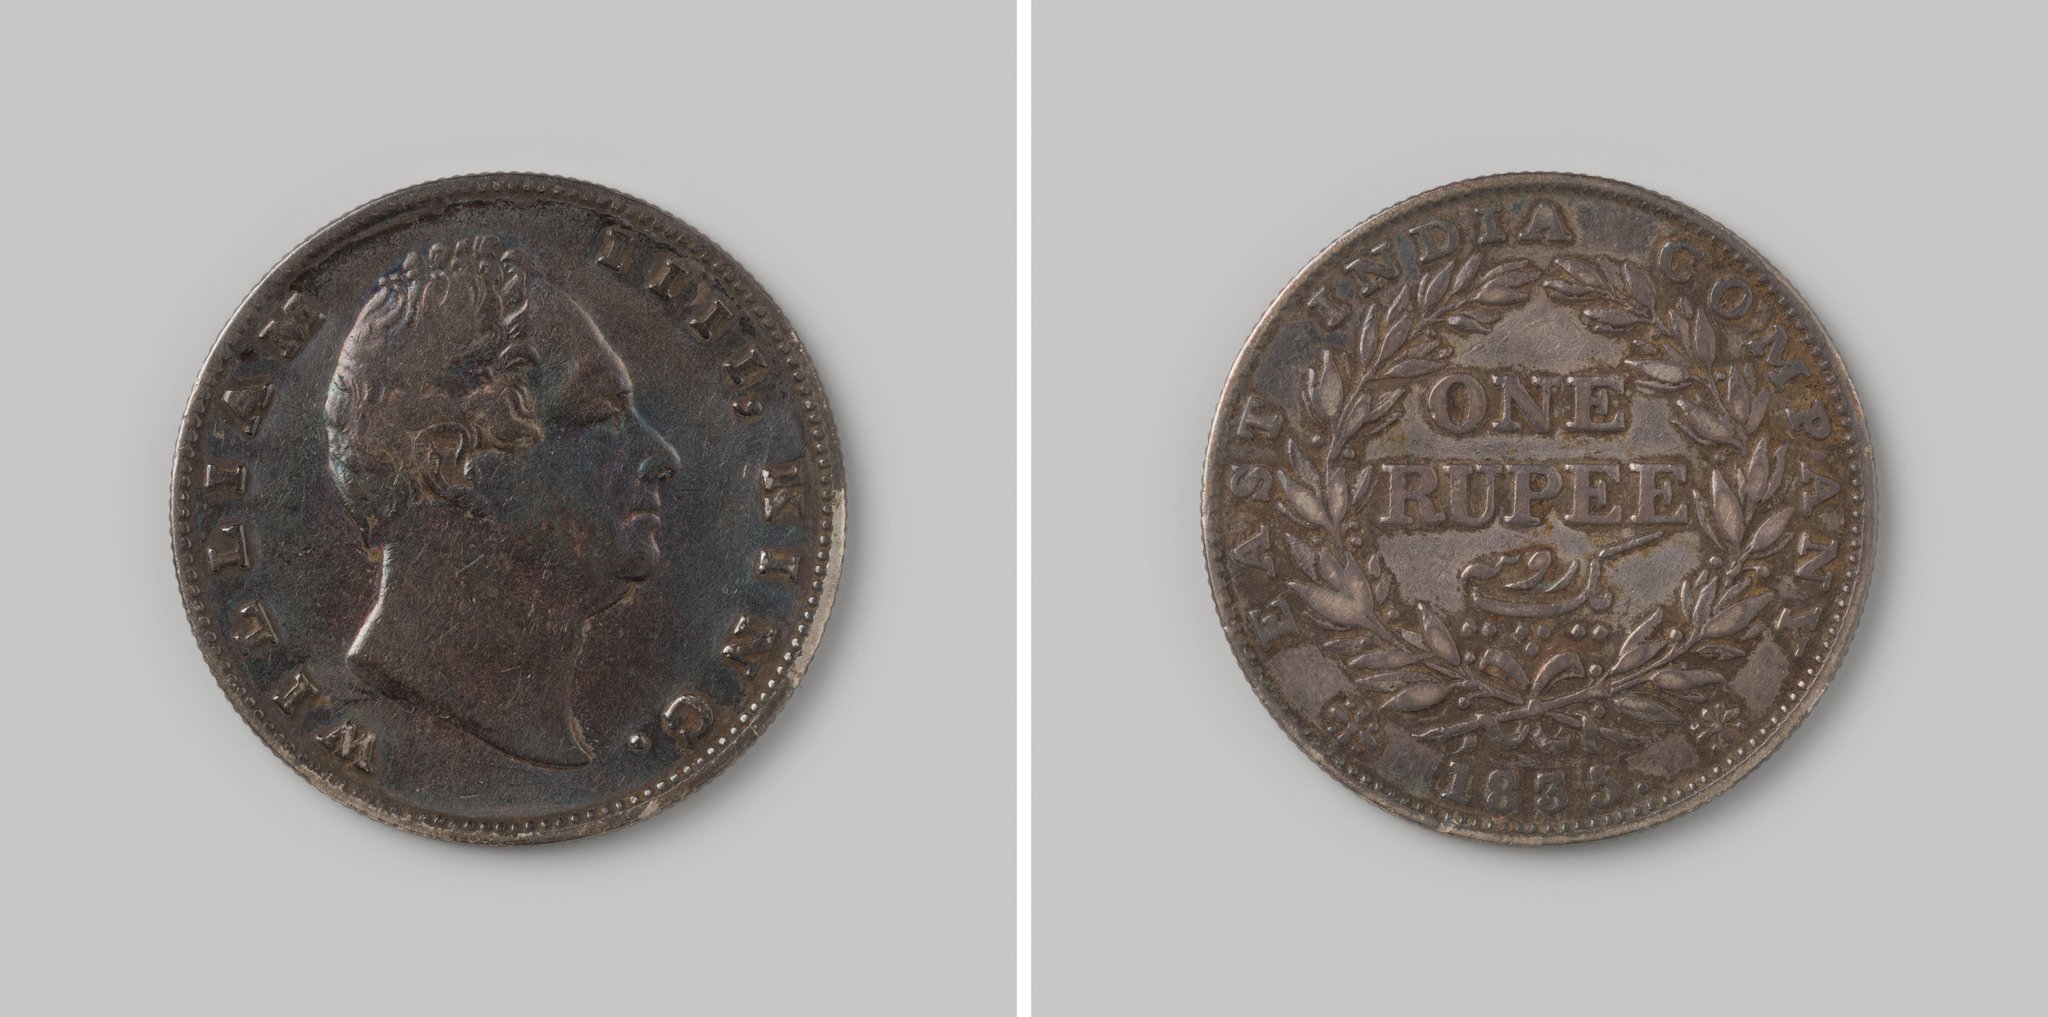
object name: coin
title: Roepie uit India van de Engelse Oostindische Compagnie (EIC) op naam van koning William IV, 1835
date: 1835-1840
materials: silver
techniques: striking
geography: mumbai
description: Zilveren munt. Voorzijde: hoofd van koning William IV naar rechts. Op halsafsnede geen aanduiding. Keerzijde: tussen twee samengebonden takken in twee regels waarde-aanduiding: one rupee, waaronder in Arabische lettertekens in een regel waarde-aanduiding. Onderaan jaartal. Kartelrand.